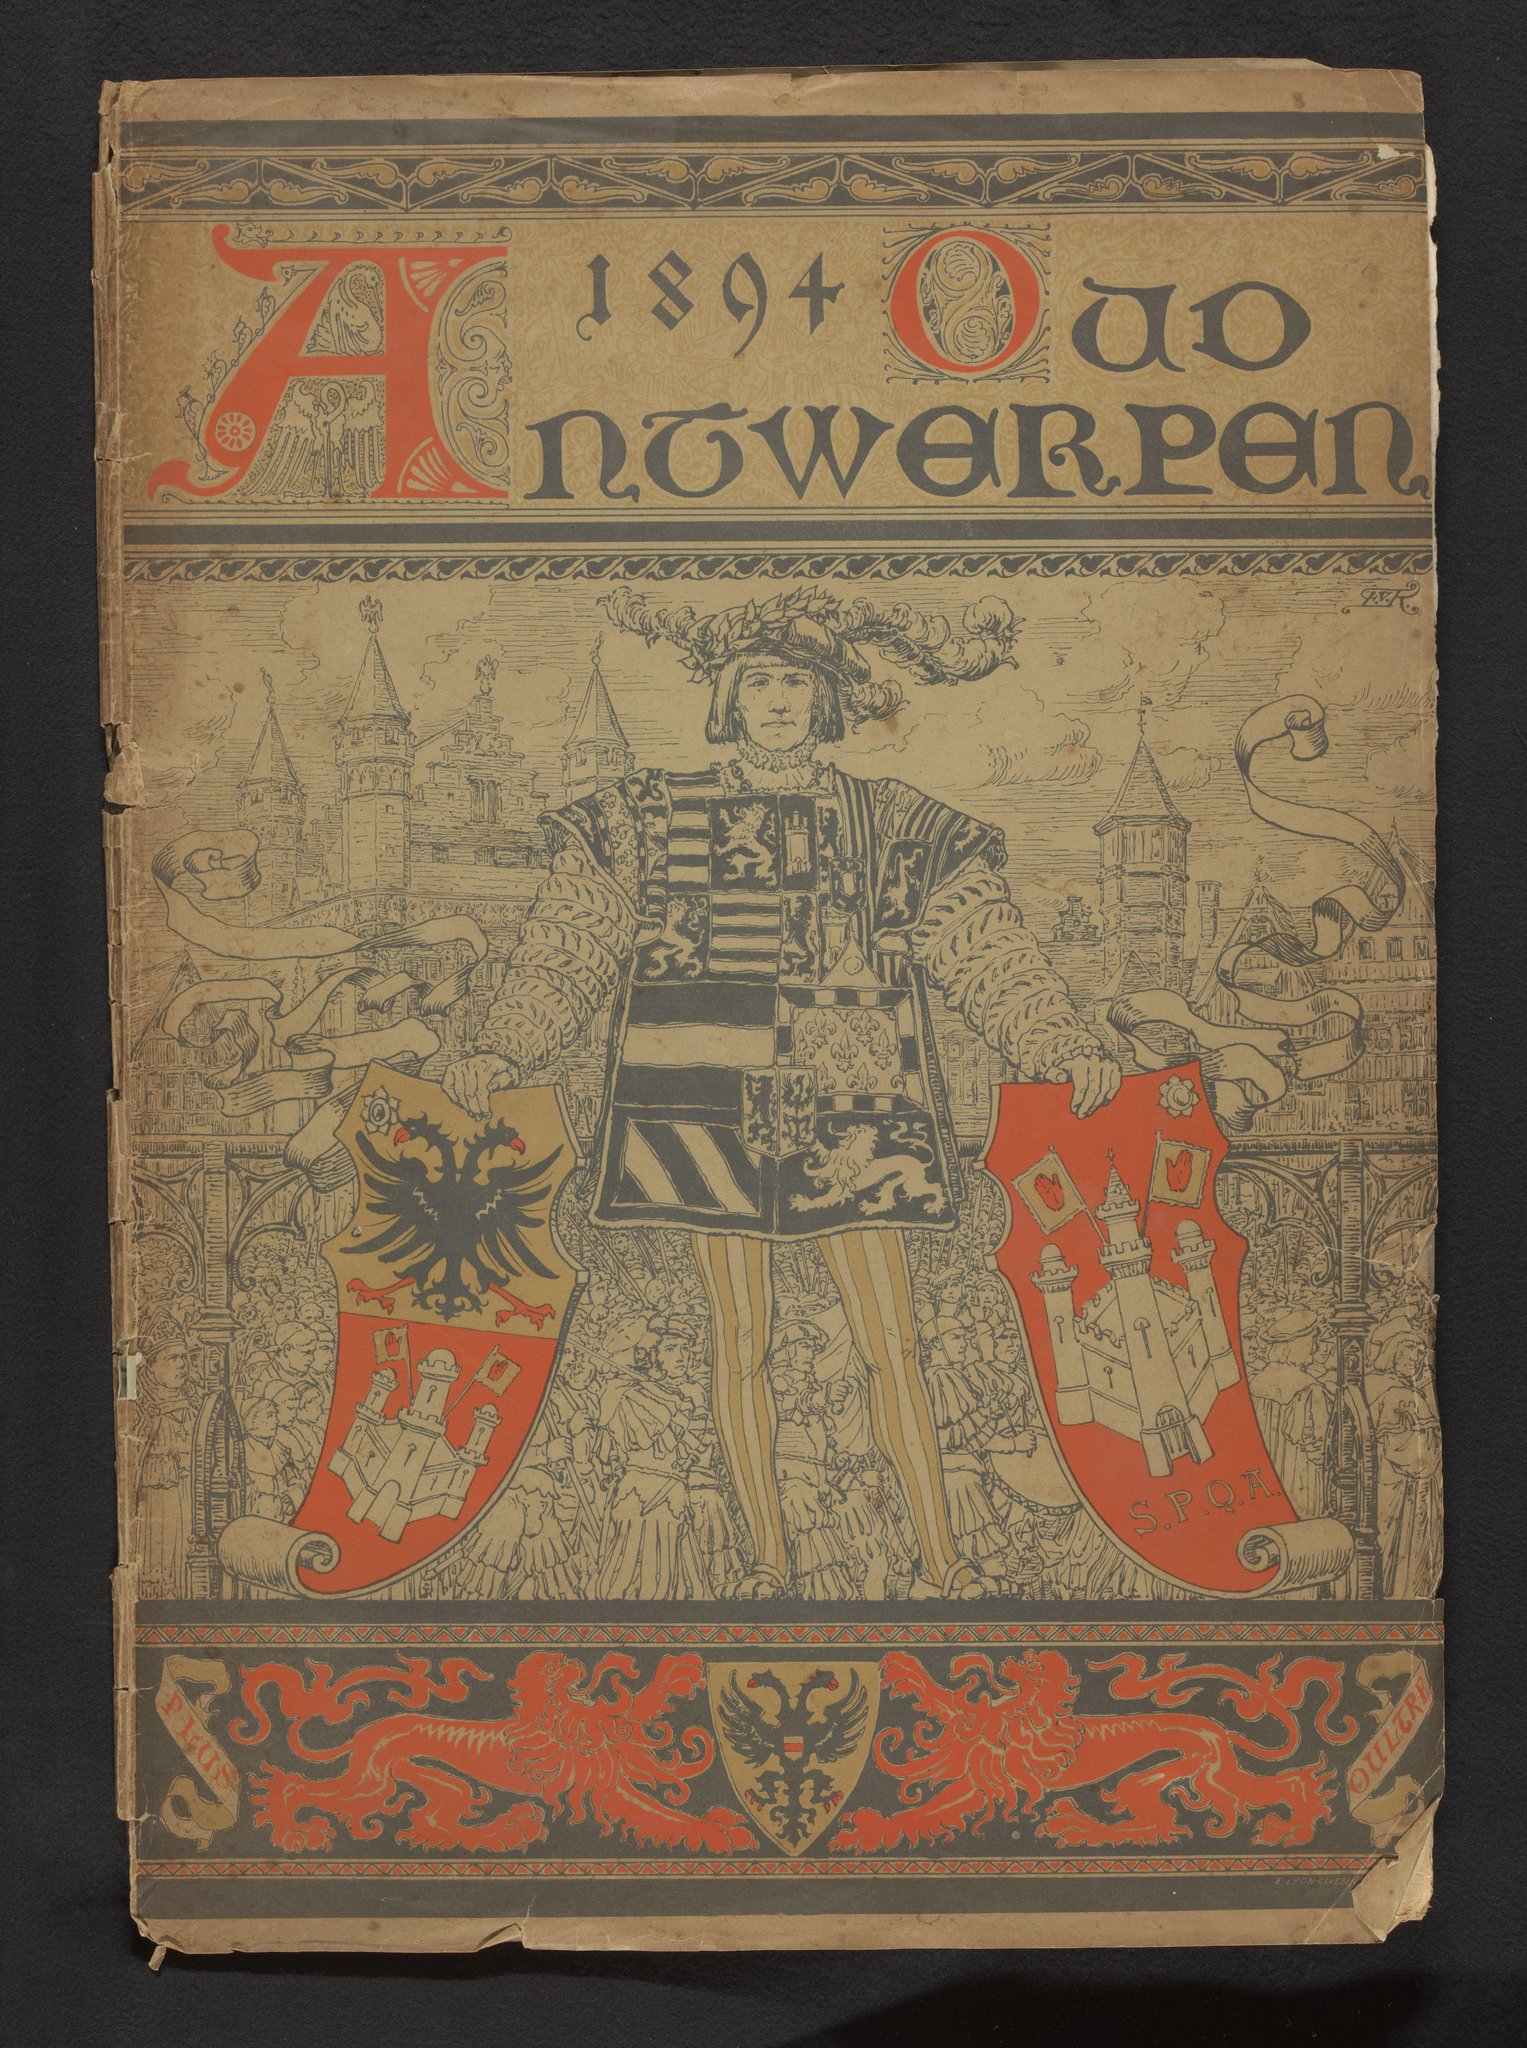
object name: book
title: De wijk Oud-Antwerpen in de wereldtentoonstelling van 1894 / in beeld gebracht door Frans van Kuyck; beschreven door Max Rooses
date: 1894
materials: paper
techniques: photograph, lithograph, printing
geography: brussels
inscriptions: annotation: ‘6 fasc[..]s 5000/ cs/k’